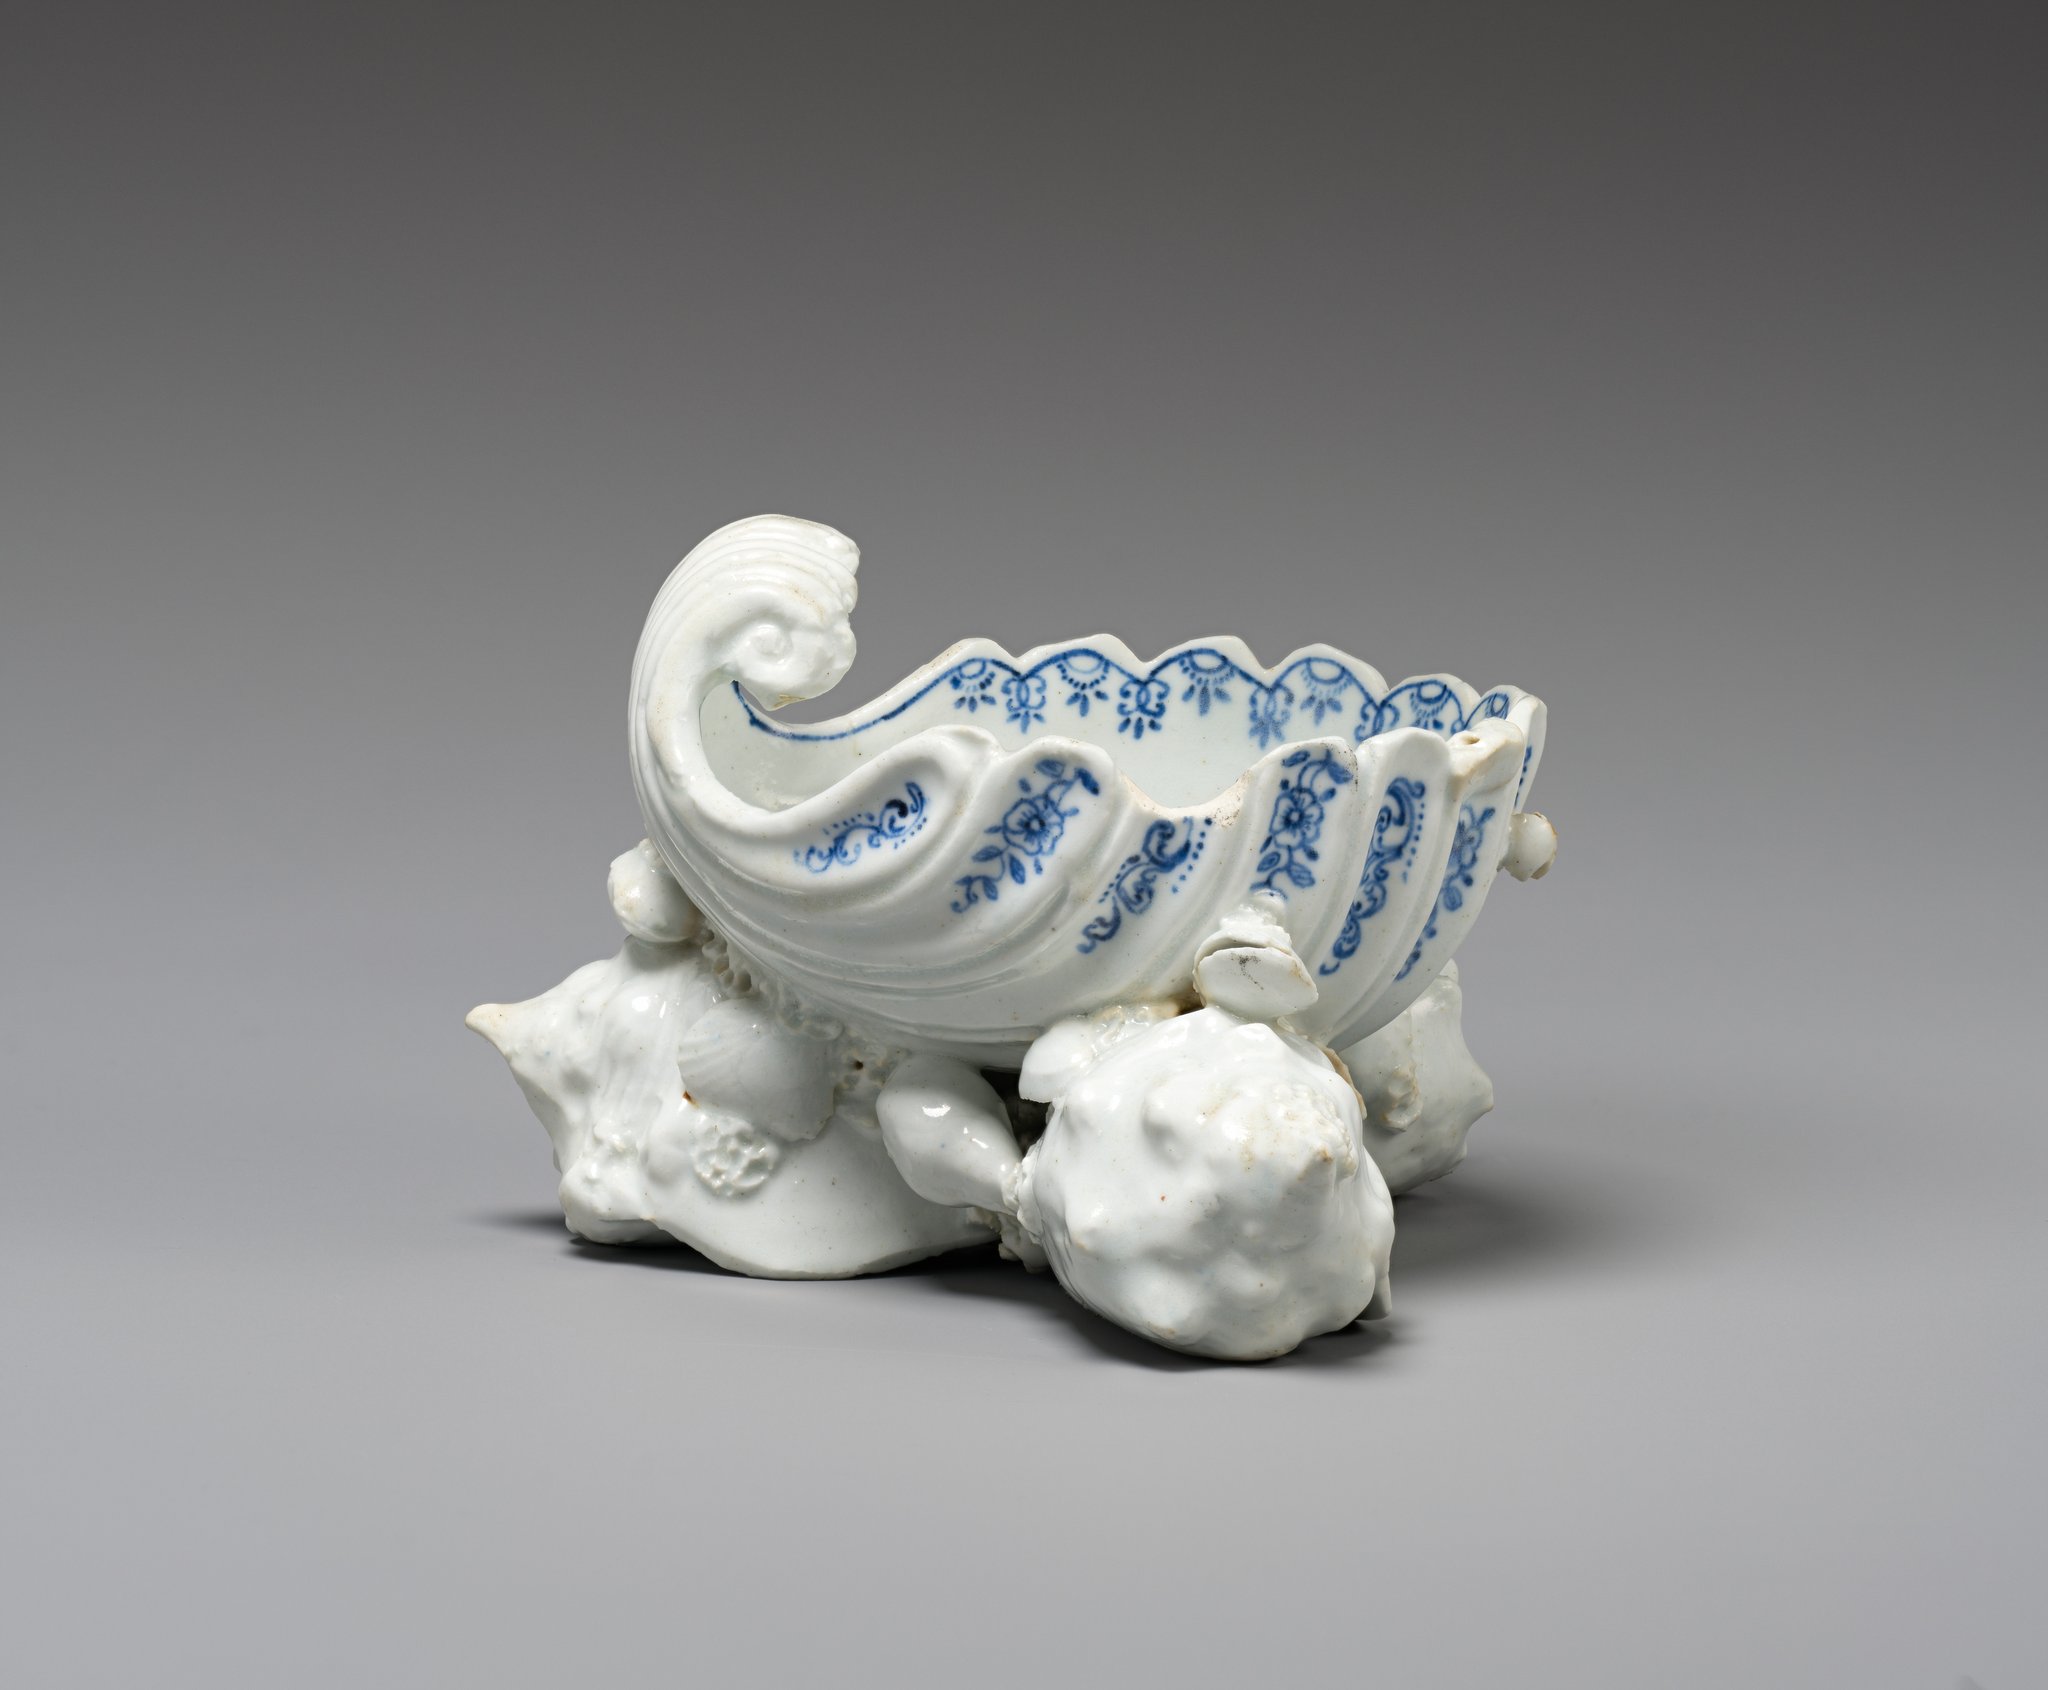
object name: sweetmeat dish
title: Sweetmeat dish (one of a pair)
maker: bow porcelain factory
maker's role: factory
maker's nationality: british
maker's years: 1747-1776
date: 1750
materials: soft paste porcelain